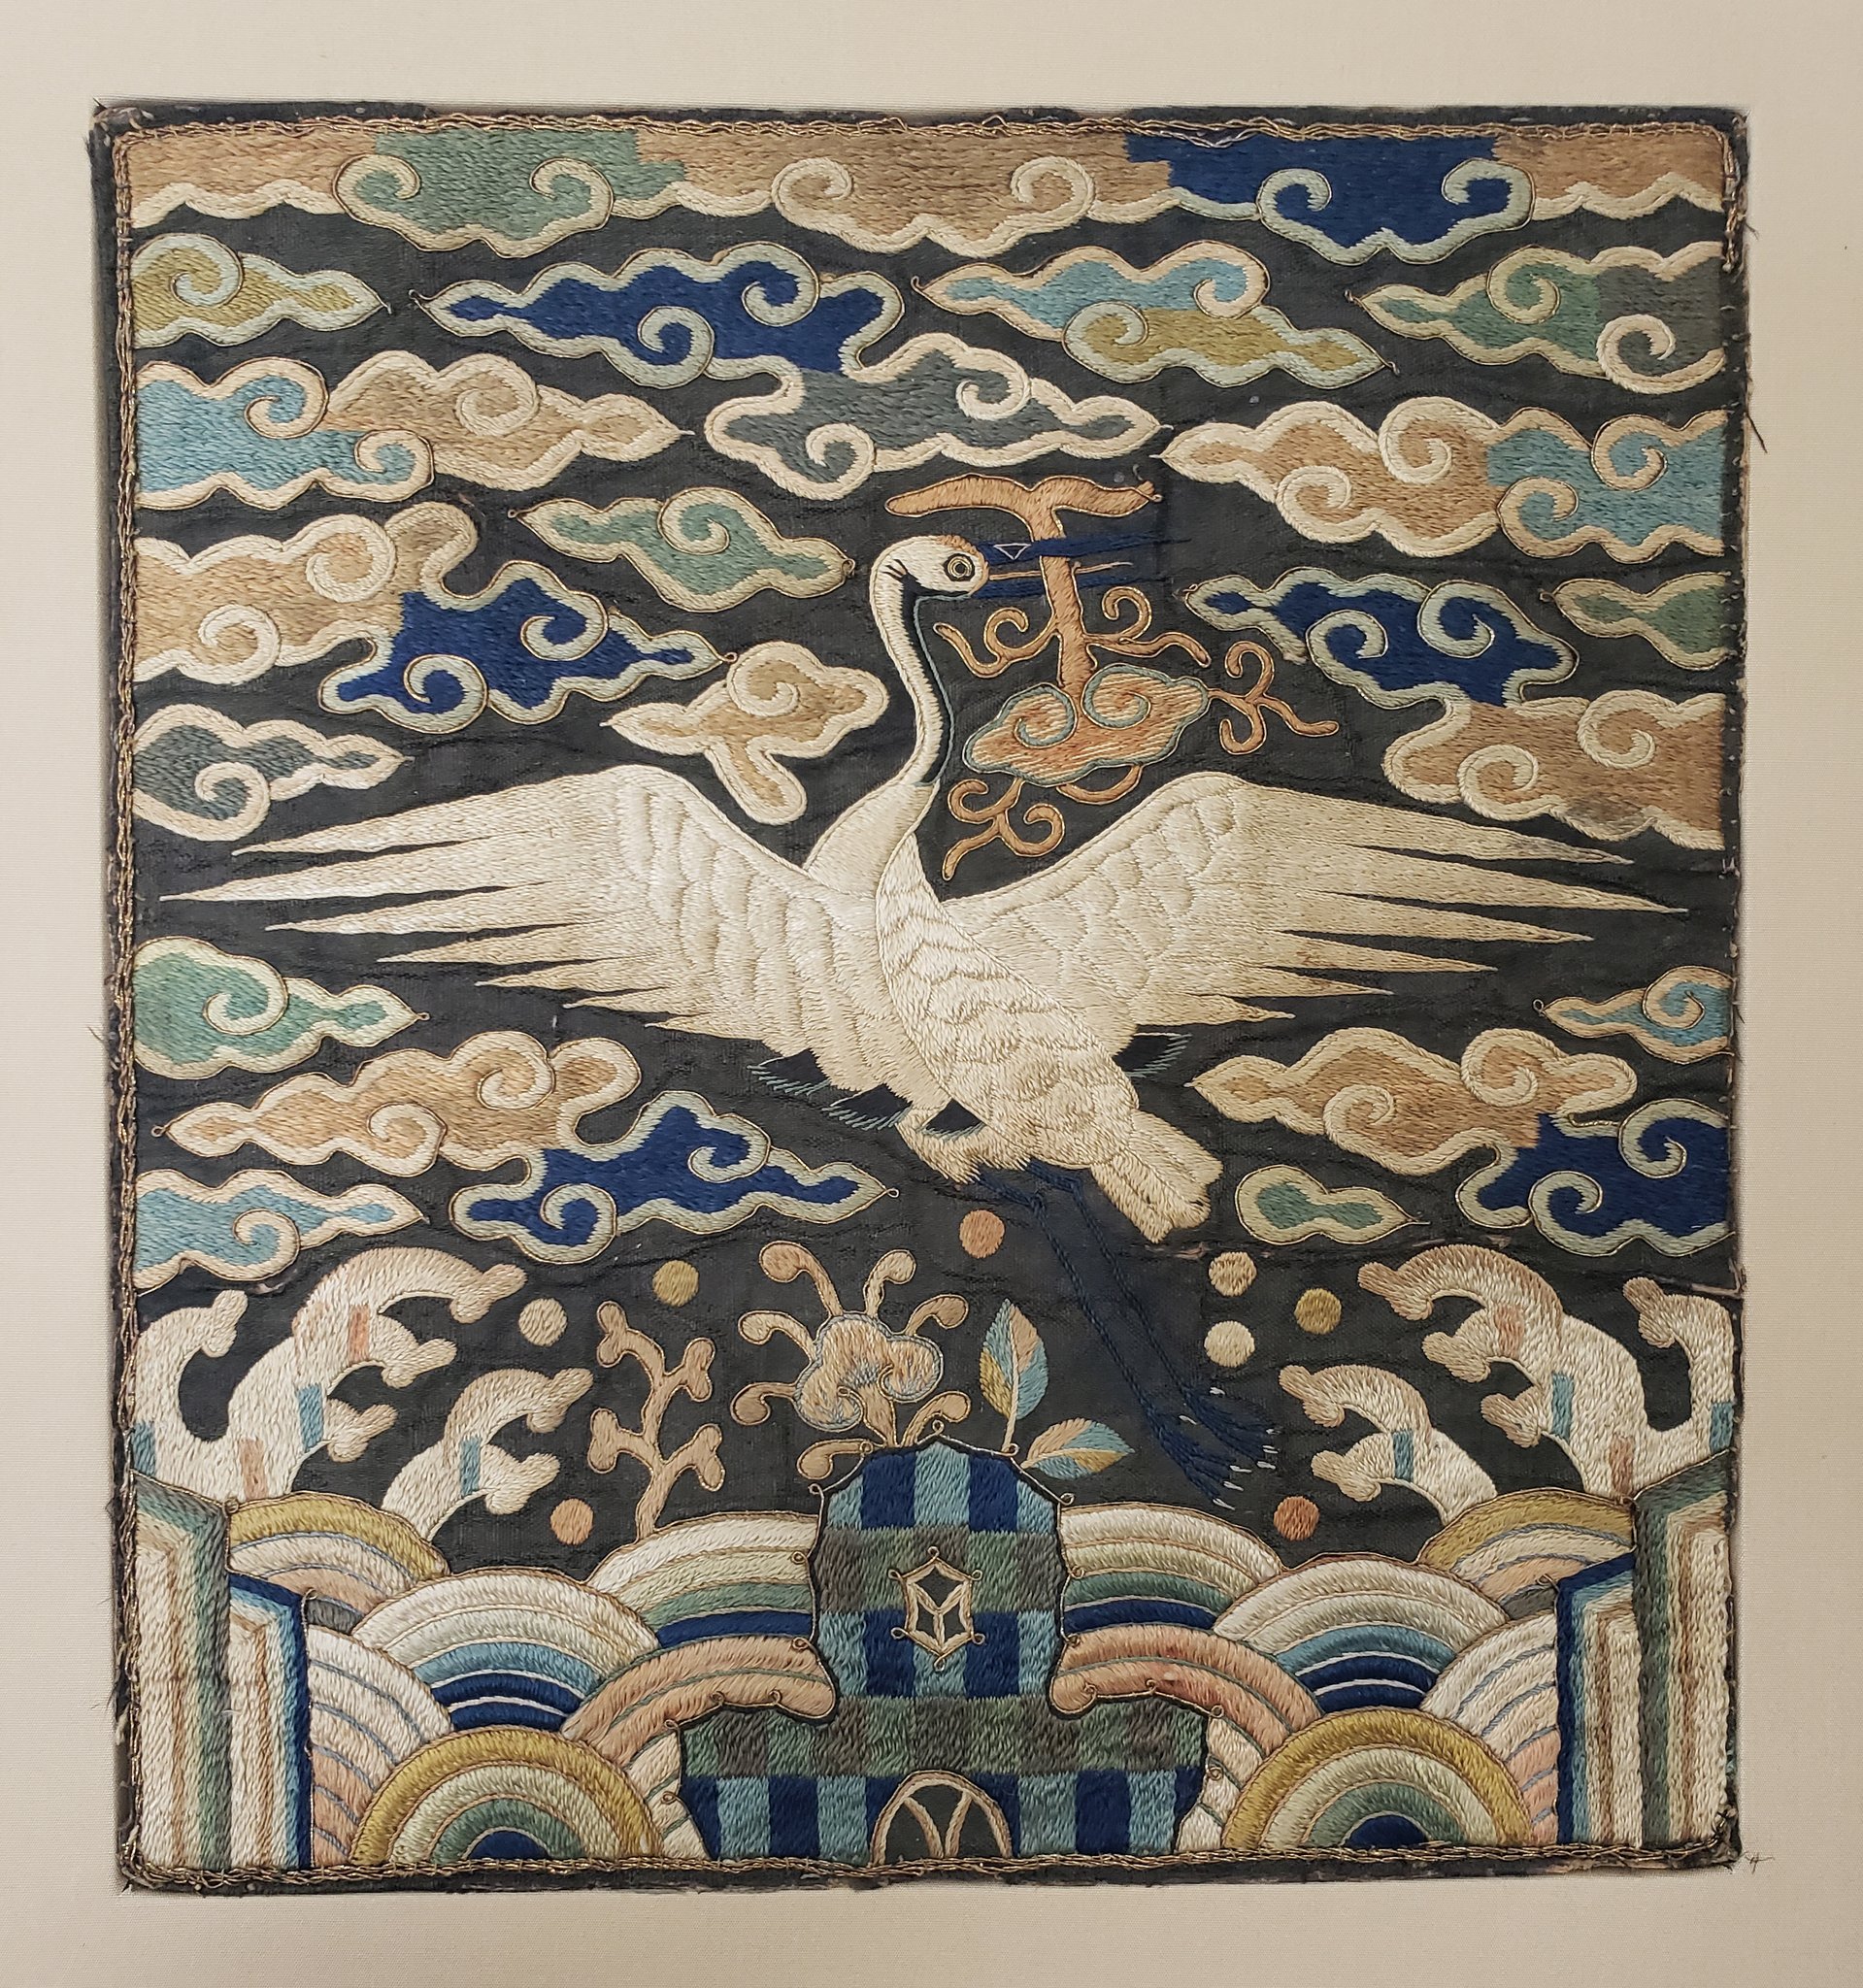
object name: rank badge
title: Rank badge with a crane (one of a pair)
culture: korean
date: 1867-1900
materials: metal thread, silk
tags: cranes